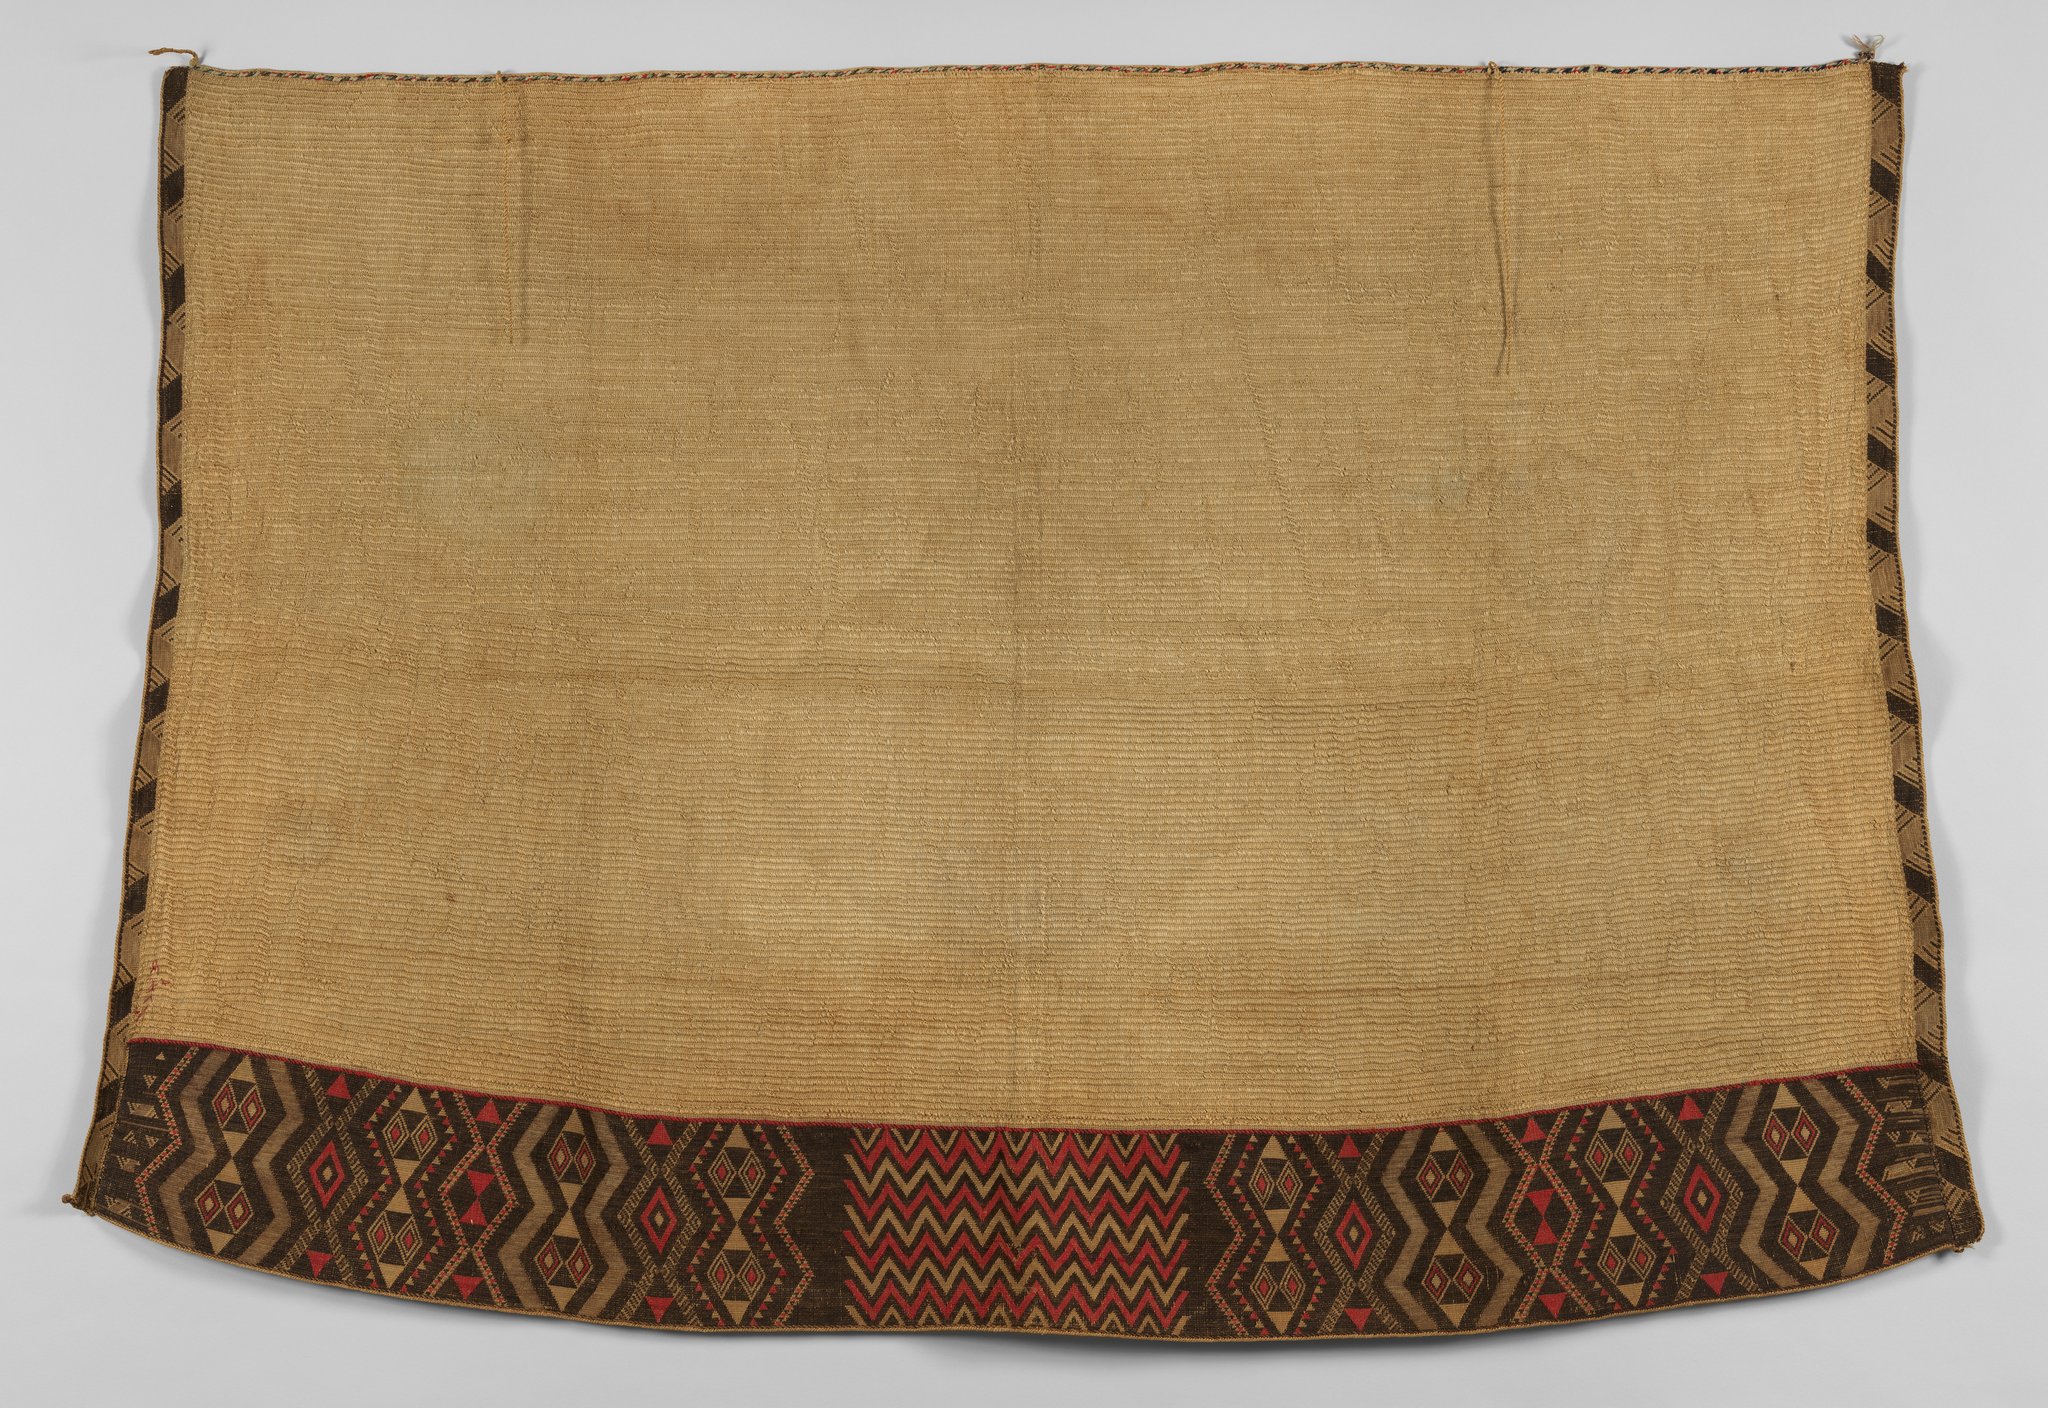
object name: cloak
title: Cloak (Kaitaka aronui)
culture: maori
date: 1834-1866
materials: wool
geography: new zealand